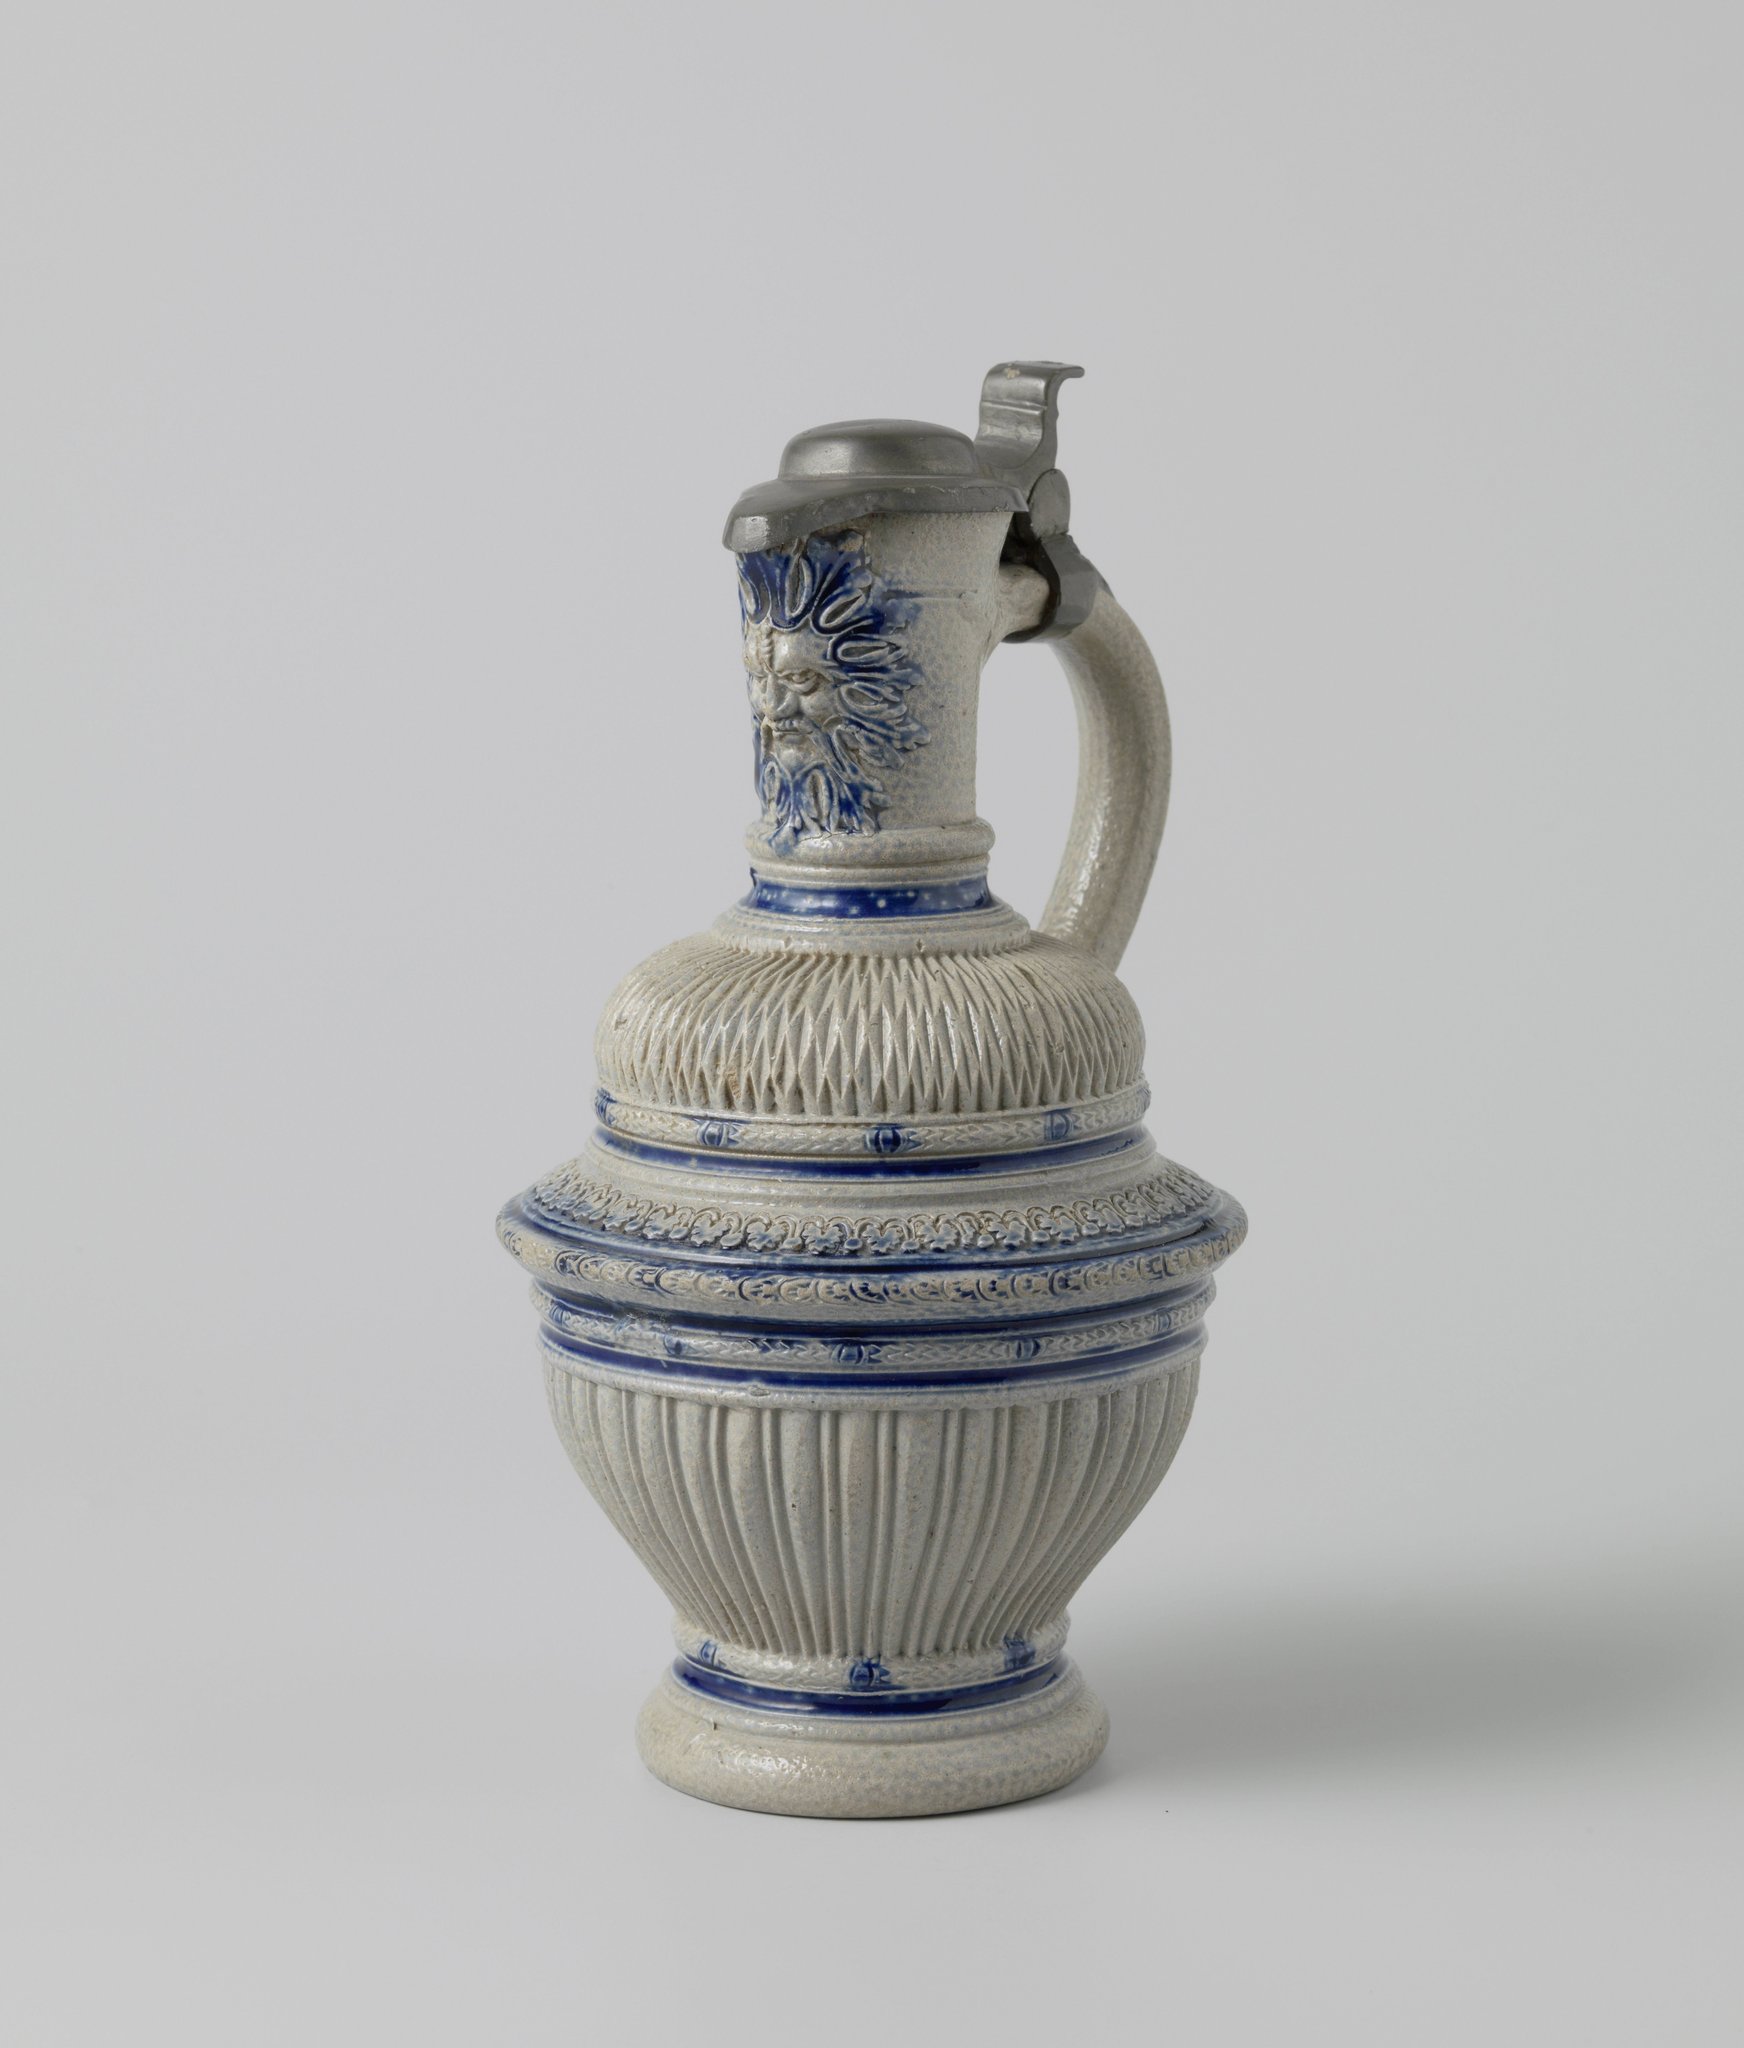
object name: ewer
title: Jug with a mask, fluting and chip carving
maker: Anonymous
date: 1590-1610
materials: cobalt, glaze, stoneware, tin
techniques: printing, firing, forming, relief, turning, vitrification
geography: raeren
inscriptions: mark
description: Kan van steengoed op hoge voet met een eivormig lichaam en smalle nek met geknepen tuit. Het oor is bevestigd aan de nek en schouder. Profielen op de nek, buik en voet. Gedeeltelijk bedekt met kobaltblauw. Het onderste deel van de buik met canelures en het breedste deel met profielen en een gestempelde decoratie. De gewelfde schouder is iets smaller dan de buik en gedecoreerd met kerfsnede. Op de nek in reliëf een gedrukt en opgelegd masker. Bevestigd aan het oor een tinnen montuur met deksel met aan de binnenzijde een onleesbaar merk. Raeren.